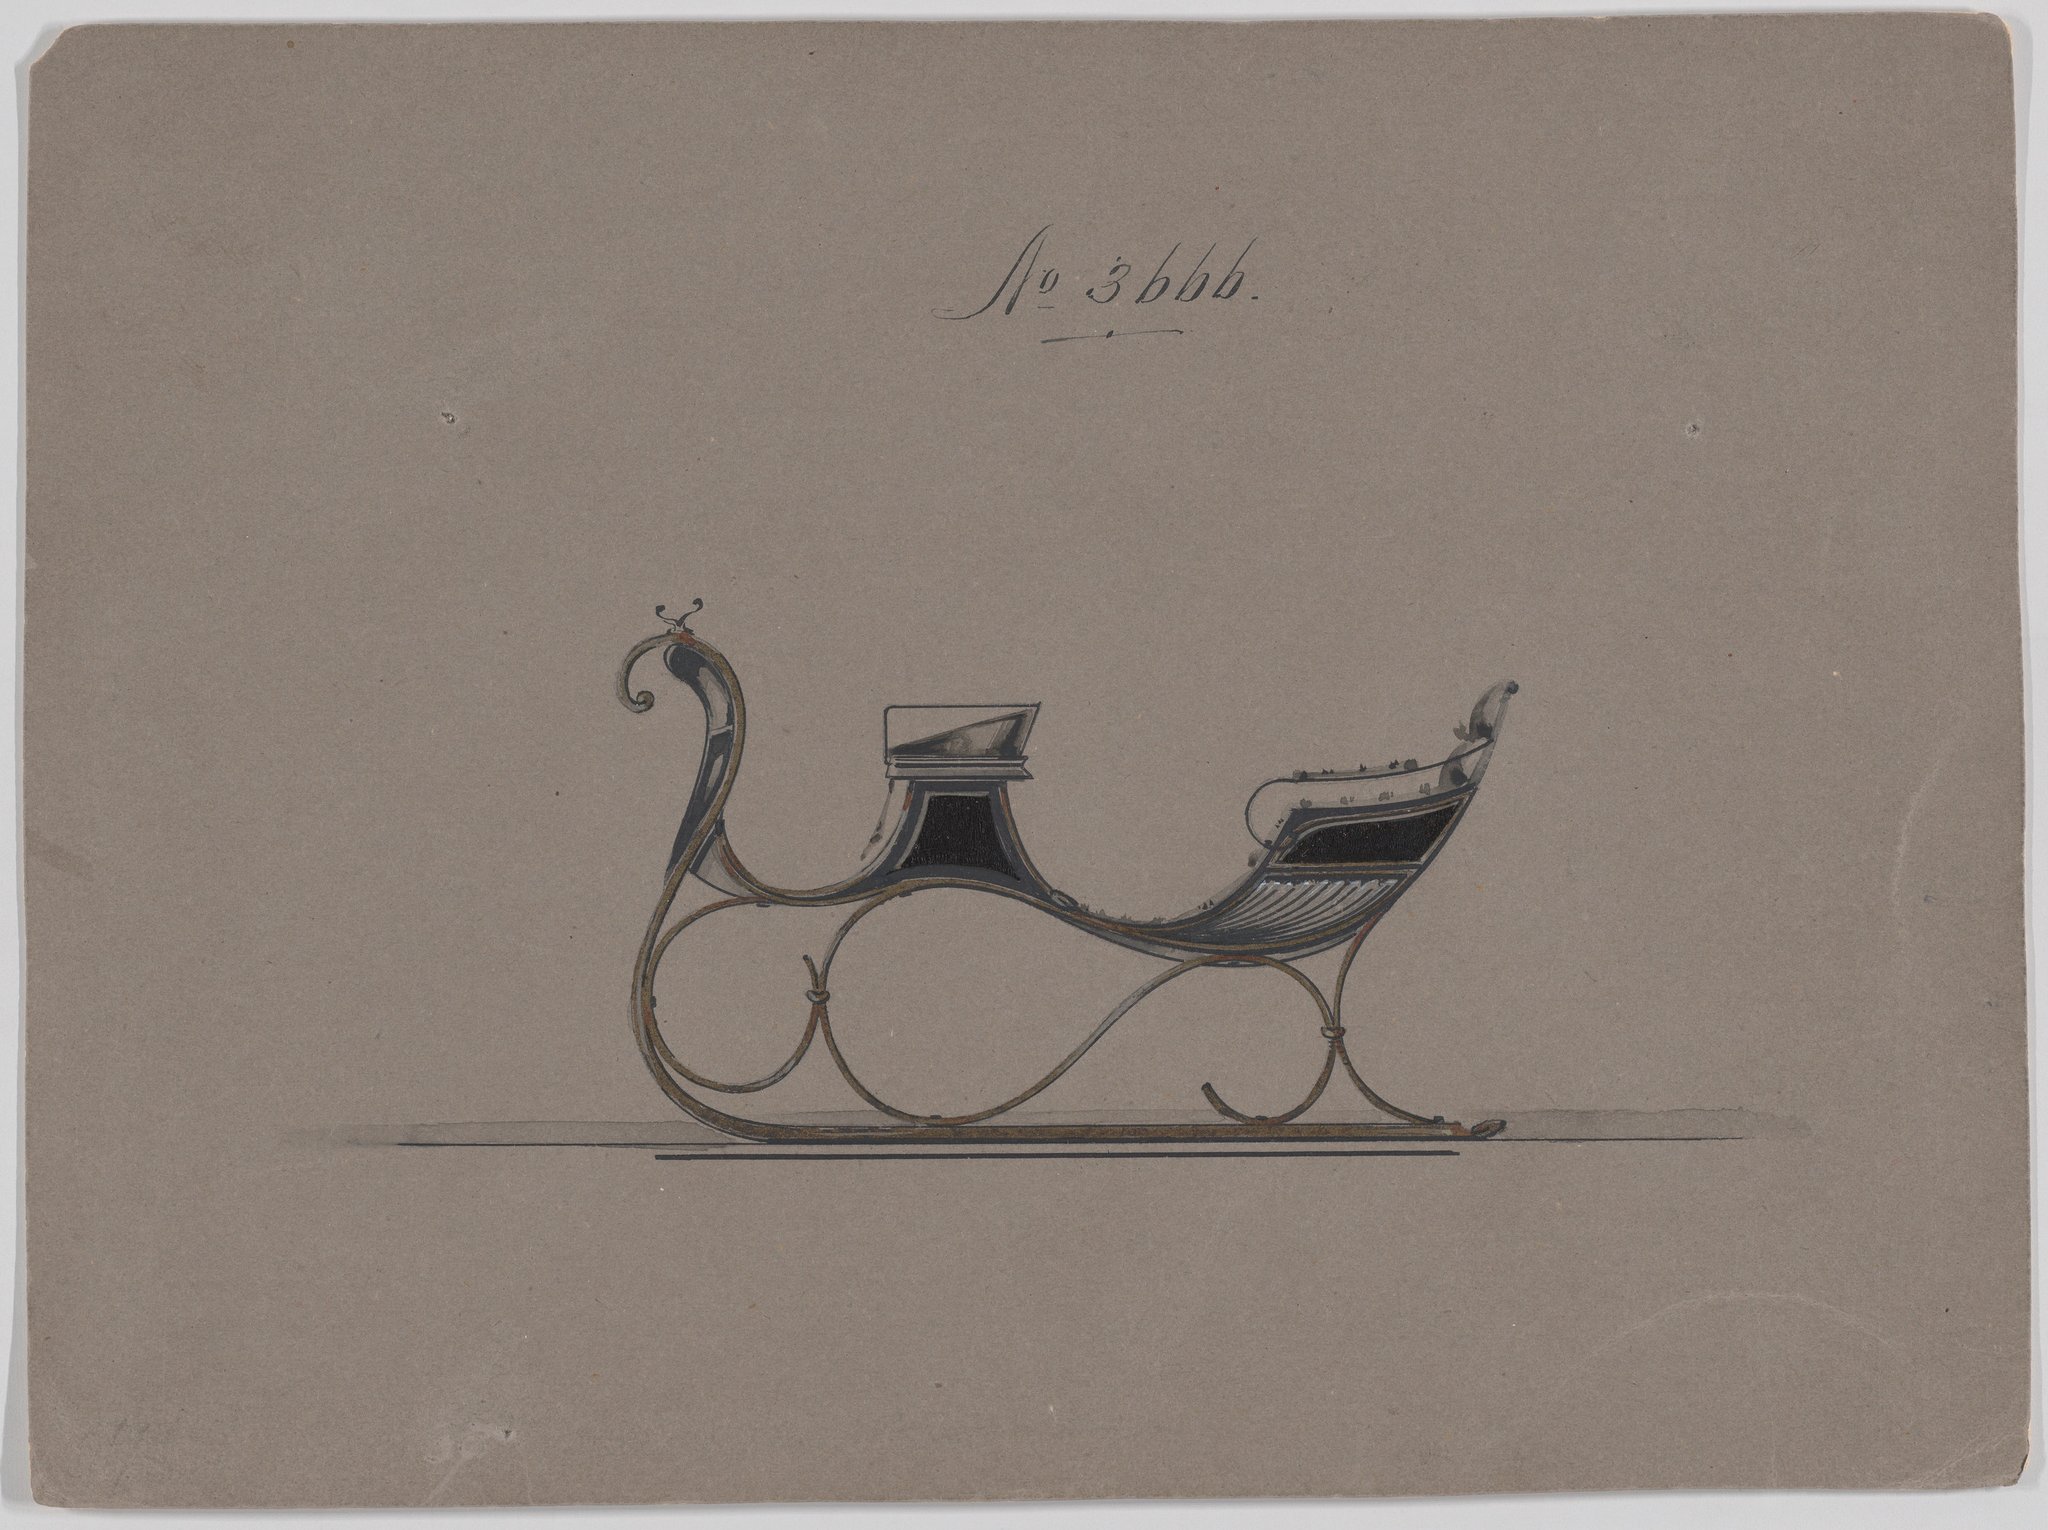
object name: drawing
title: Design for 4 Seat Sleigh, no. 3666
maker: brewster & co.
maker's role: manufacturer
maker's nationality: american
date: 1881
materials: gouache, gum arabic, ink, watercolor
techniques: pen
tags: sleighs